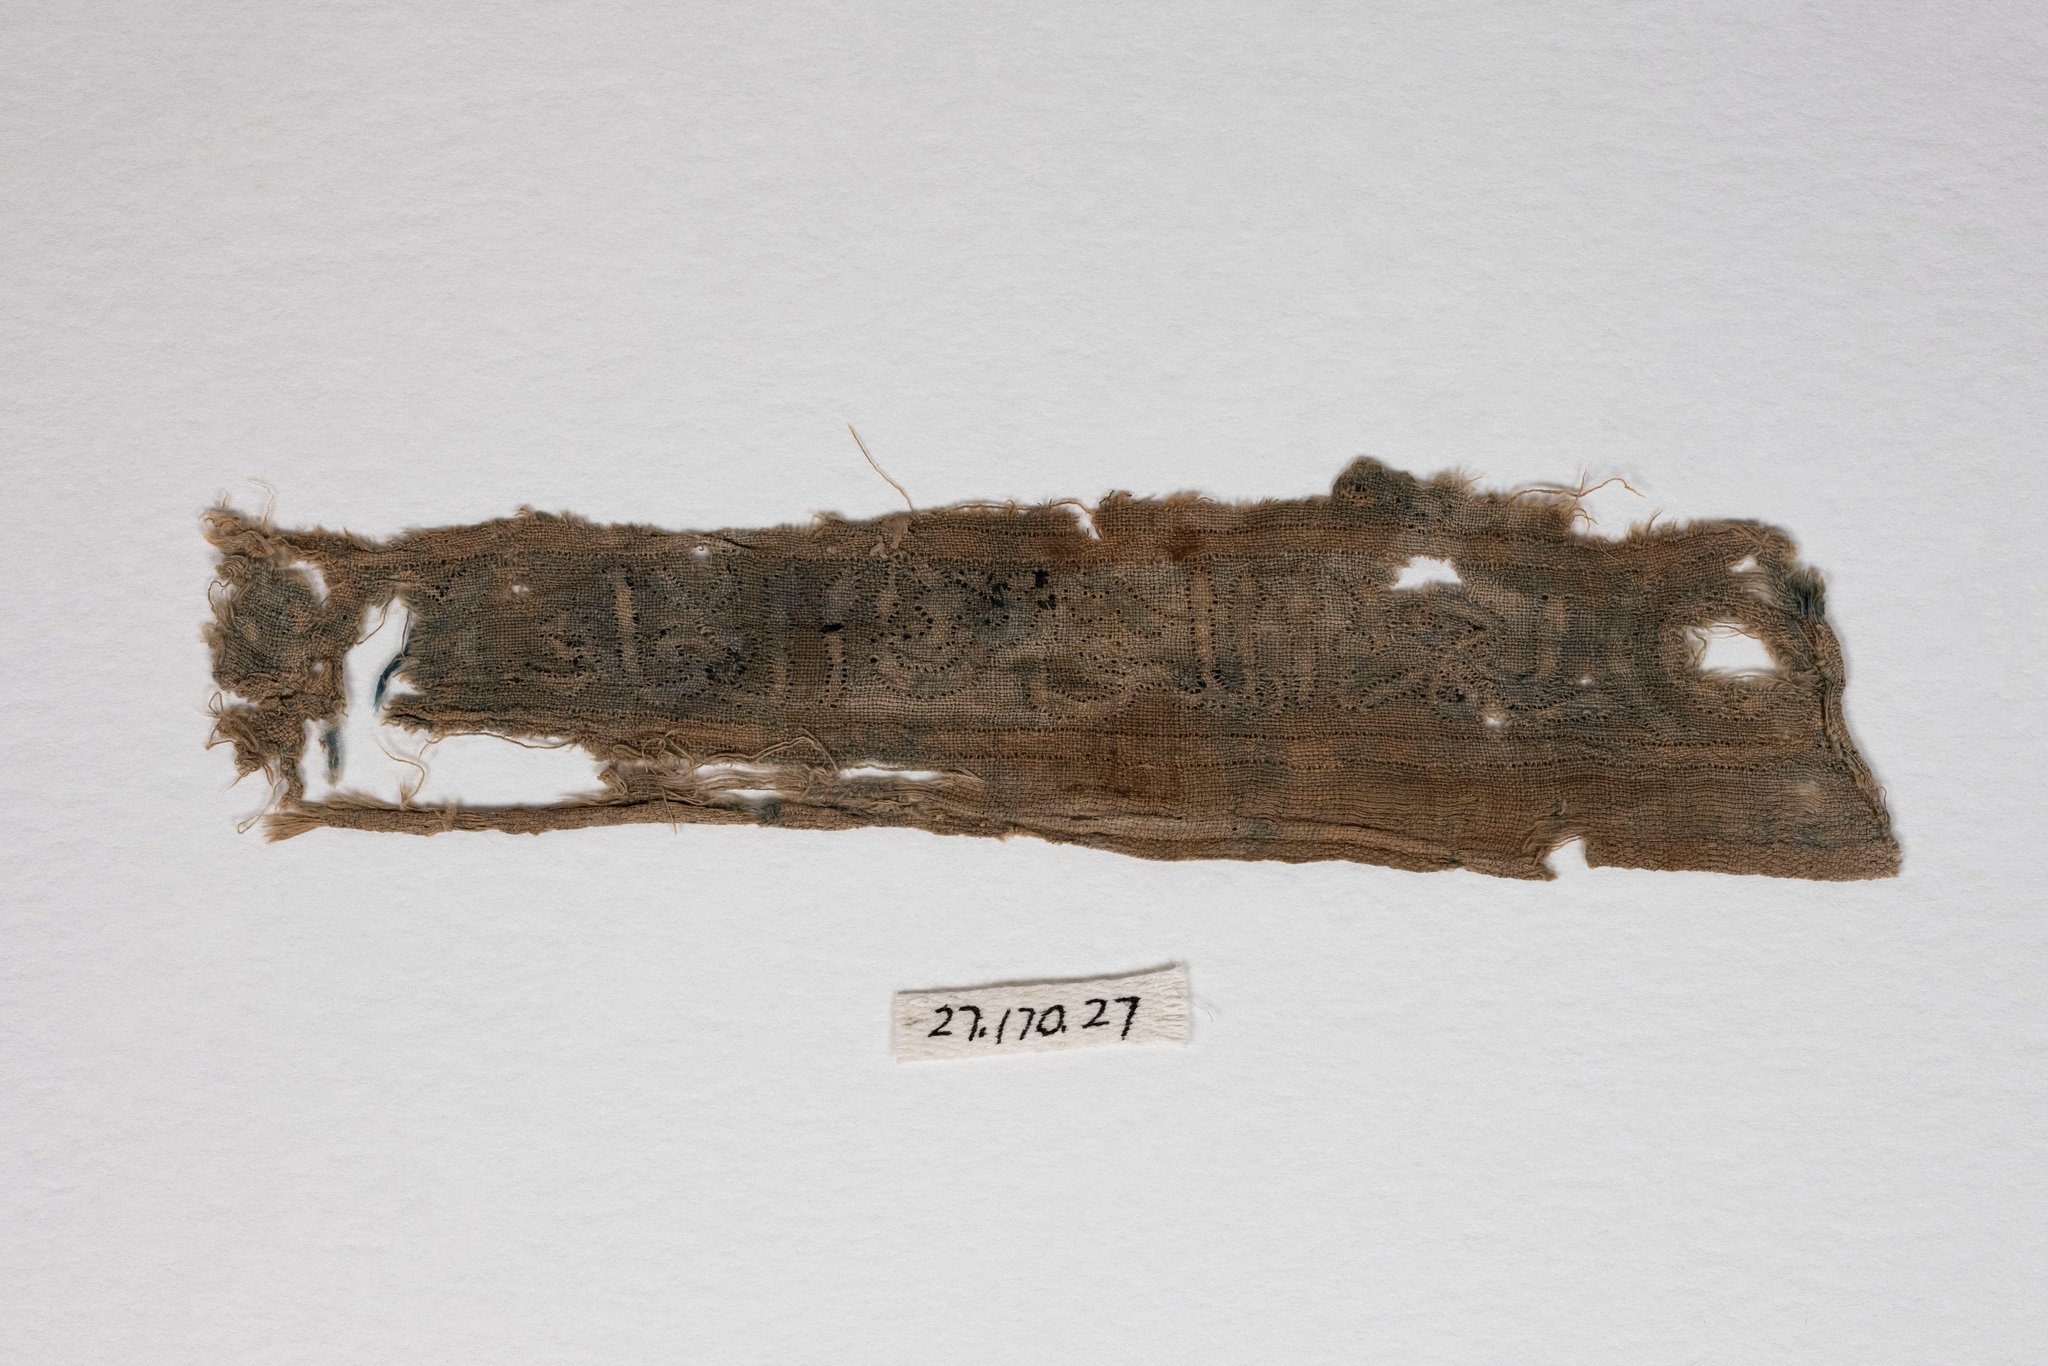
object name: band fragment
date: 1201-1400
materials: cotton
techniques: embroidery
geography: egypt